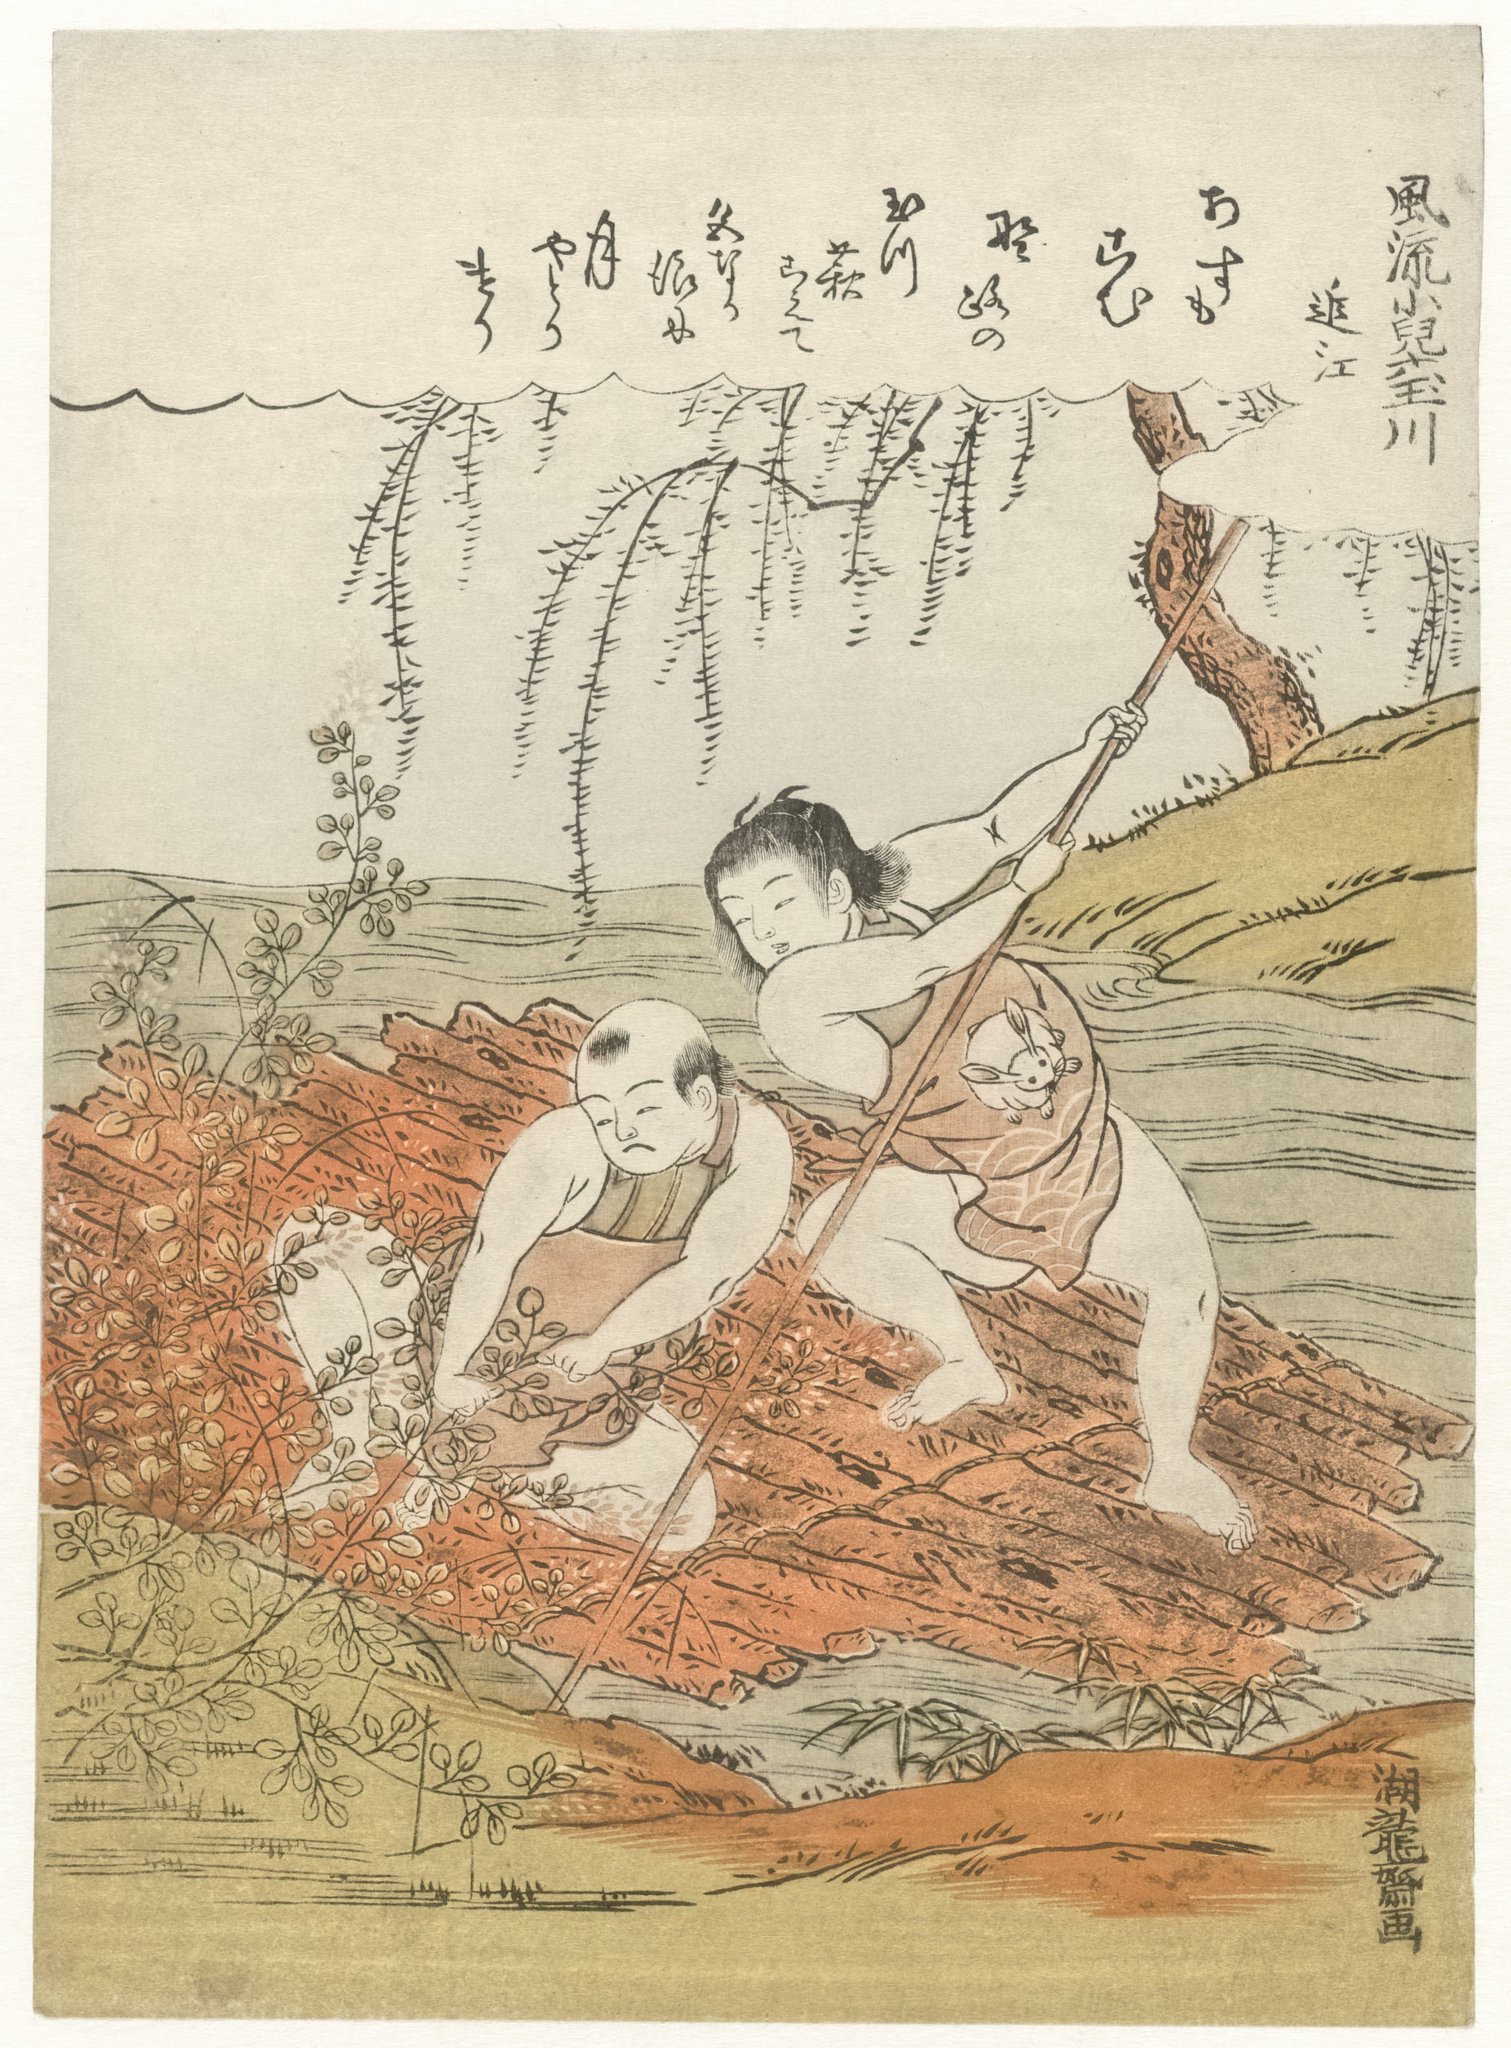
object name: print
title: Twee jongens verzamelen hagi (takken met blad) vanaf een vlot op een rivier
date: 1771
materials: paper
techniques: woodcut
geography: japan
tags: boy (child between toddler and youth), raft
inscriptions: stamp: ‘CG’ Lugt 538d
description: De jongen die het vlot voortduwt draagt een hemd met daarop een haas (verwijzing naar jaar van de haas). Uit de reeks 'Kleine kinderen op de zes ''kristallen'' rivieren'. Opschrift is een gedicht van Minamoto no Toshiyori: De maan, schijnend over de lespedeza, kwam tot leven in de kleurige golven van de kristalheldere rivier Noji, alsof, de ochtend nooit zou komen. Minamoto no Toshiyori, De Noji no tamagawa is een van de 'zes kristalheldere rivieren'. 'Hagi' is Lespedeza, een Japanse klaver, de struik waar de jongens aan trekken.